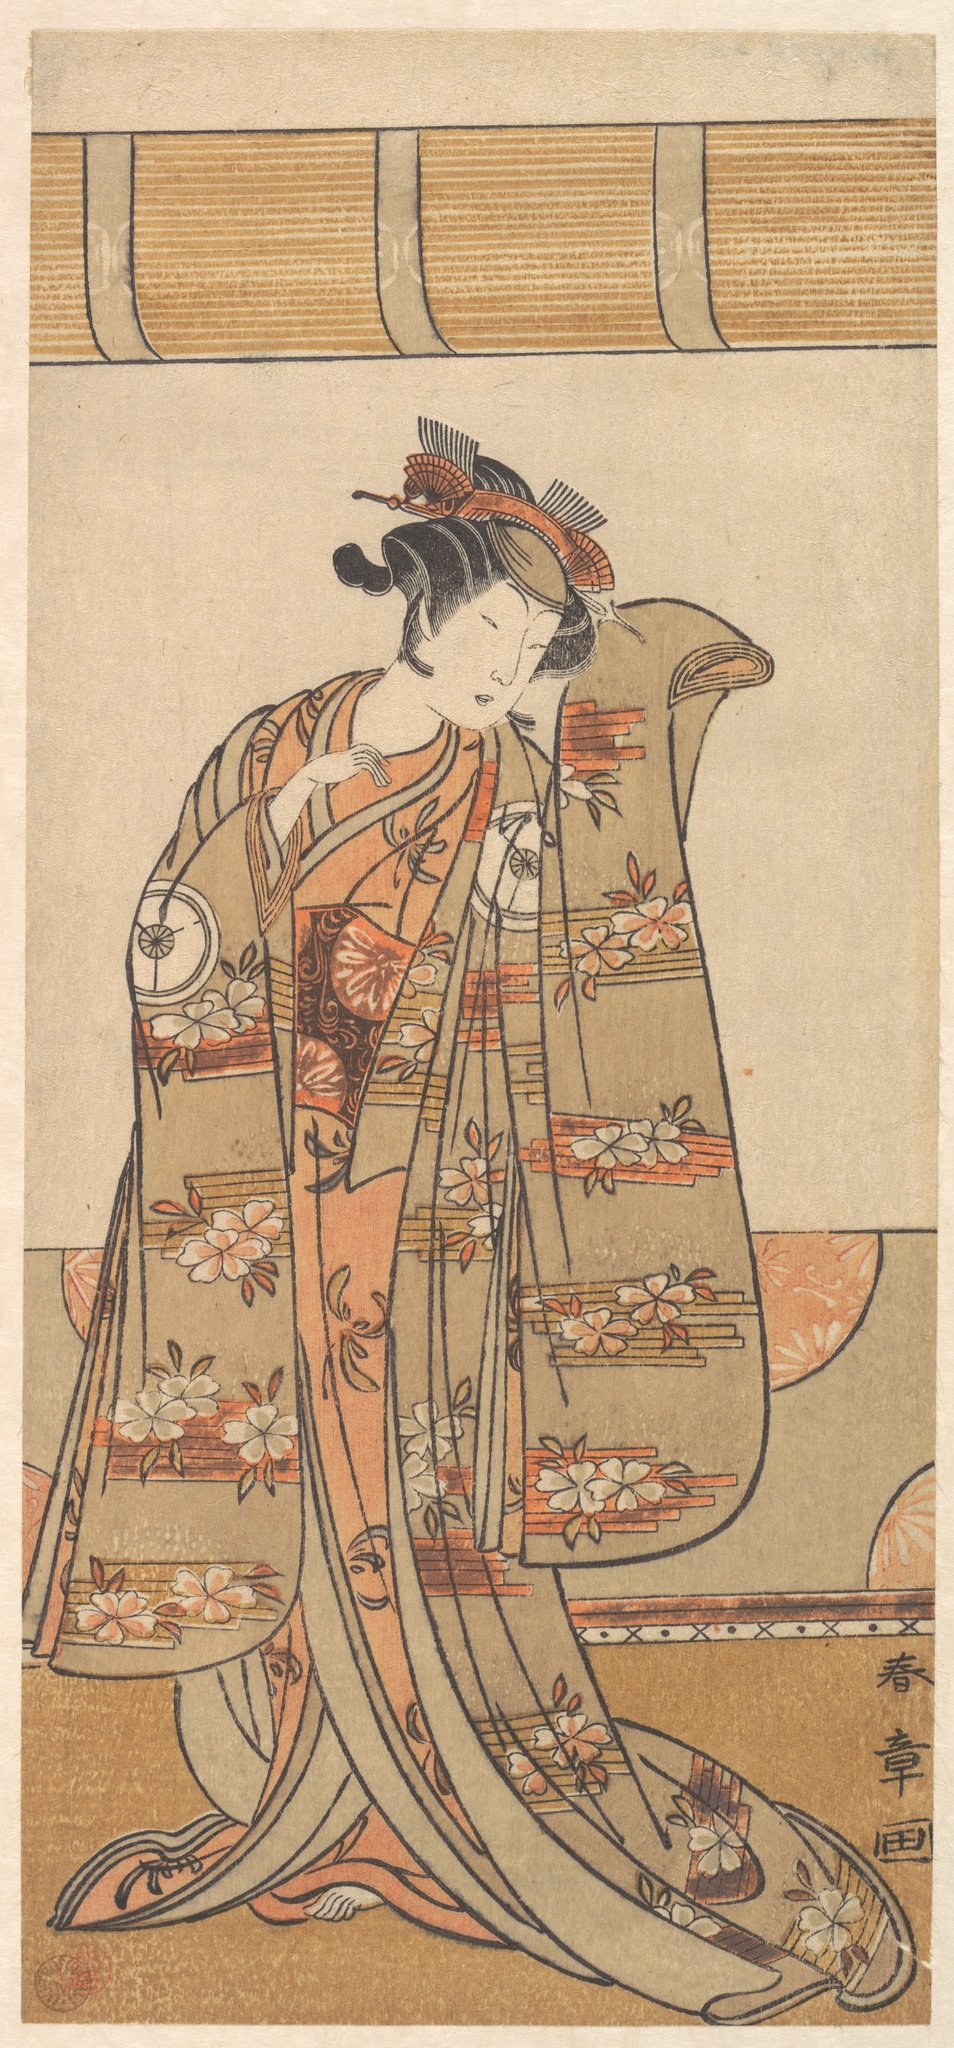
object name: woodblock print nishiki e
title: The Fourth Iwai Hanshiro as a Woman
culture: japanese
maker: katsukawa shunshō 勝川春章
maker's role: artist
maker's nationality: japanese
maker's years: 1726-1792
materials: ink, paper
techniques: nishiki e, woodblock print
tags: men,women,actors